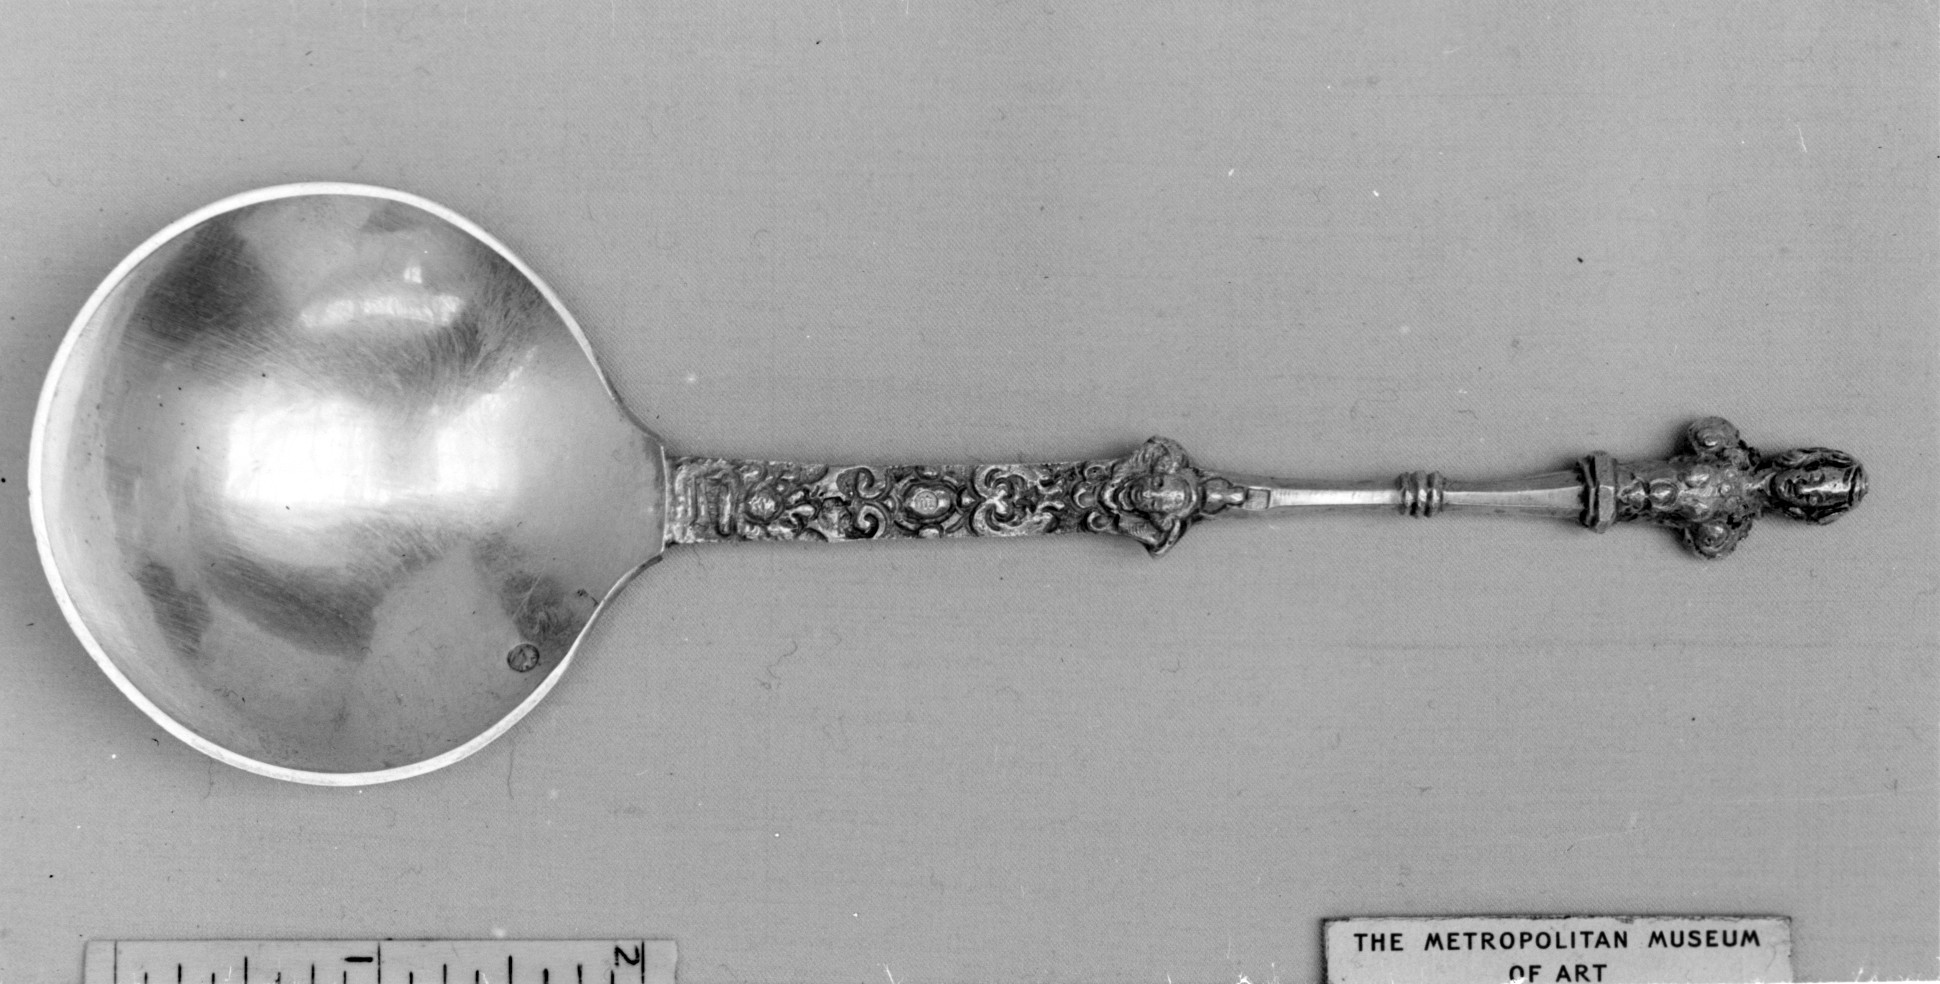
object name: spoon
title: Figure-top spoon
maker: jan van staaten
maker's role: maker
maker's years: 1846-1886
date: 1879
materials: silver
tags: heads